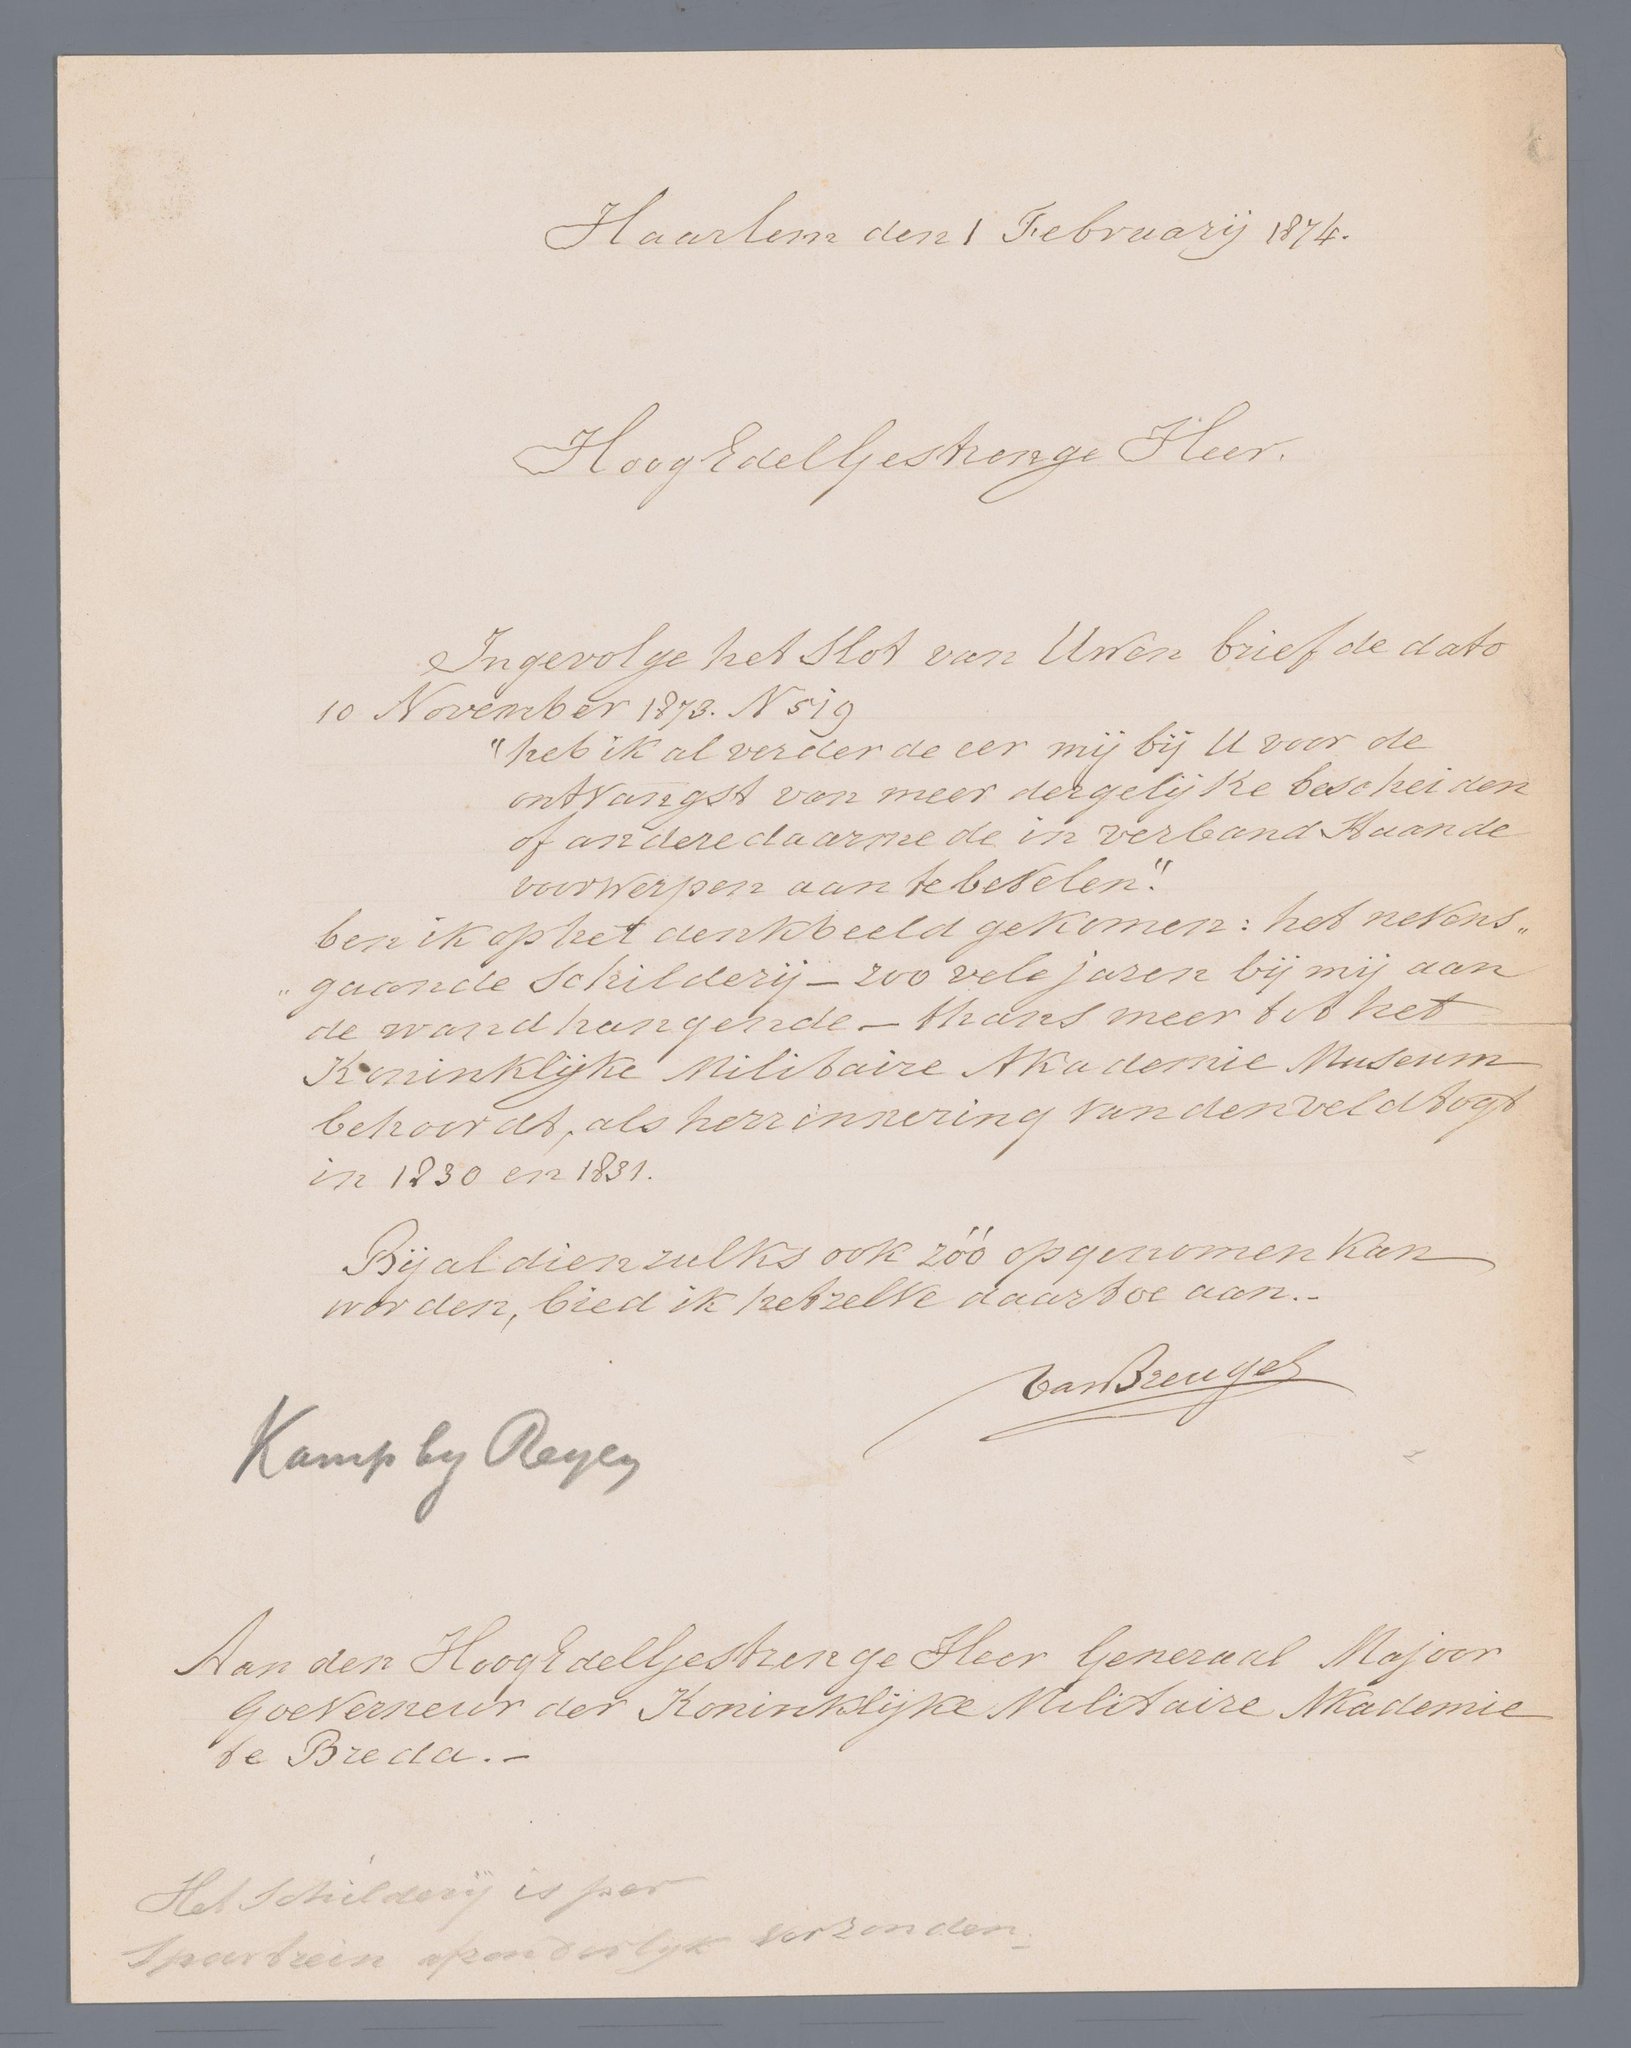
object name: letter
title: Lt. Kol. J. H. Holle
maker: van breugel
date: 1874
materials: ink, paper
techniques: writing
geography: haarlem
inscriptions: date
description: Brief, een pagina van dubbelgevouwen vel papier beschreven, gericht aan de gouveneur de K. M. A., Breda. Gesigneerd en gedateerd.